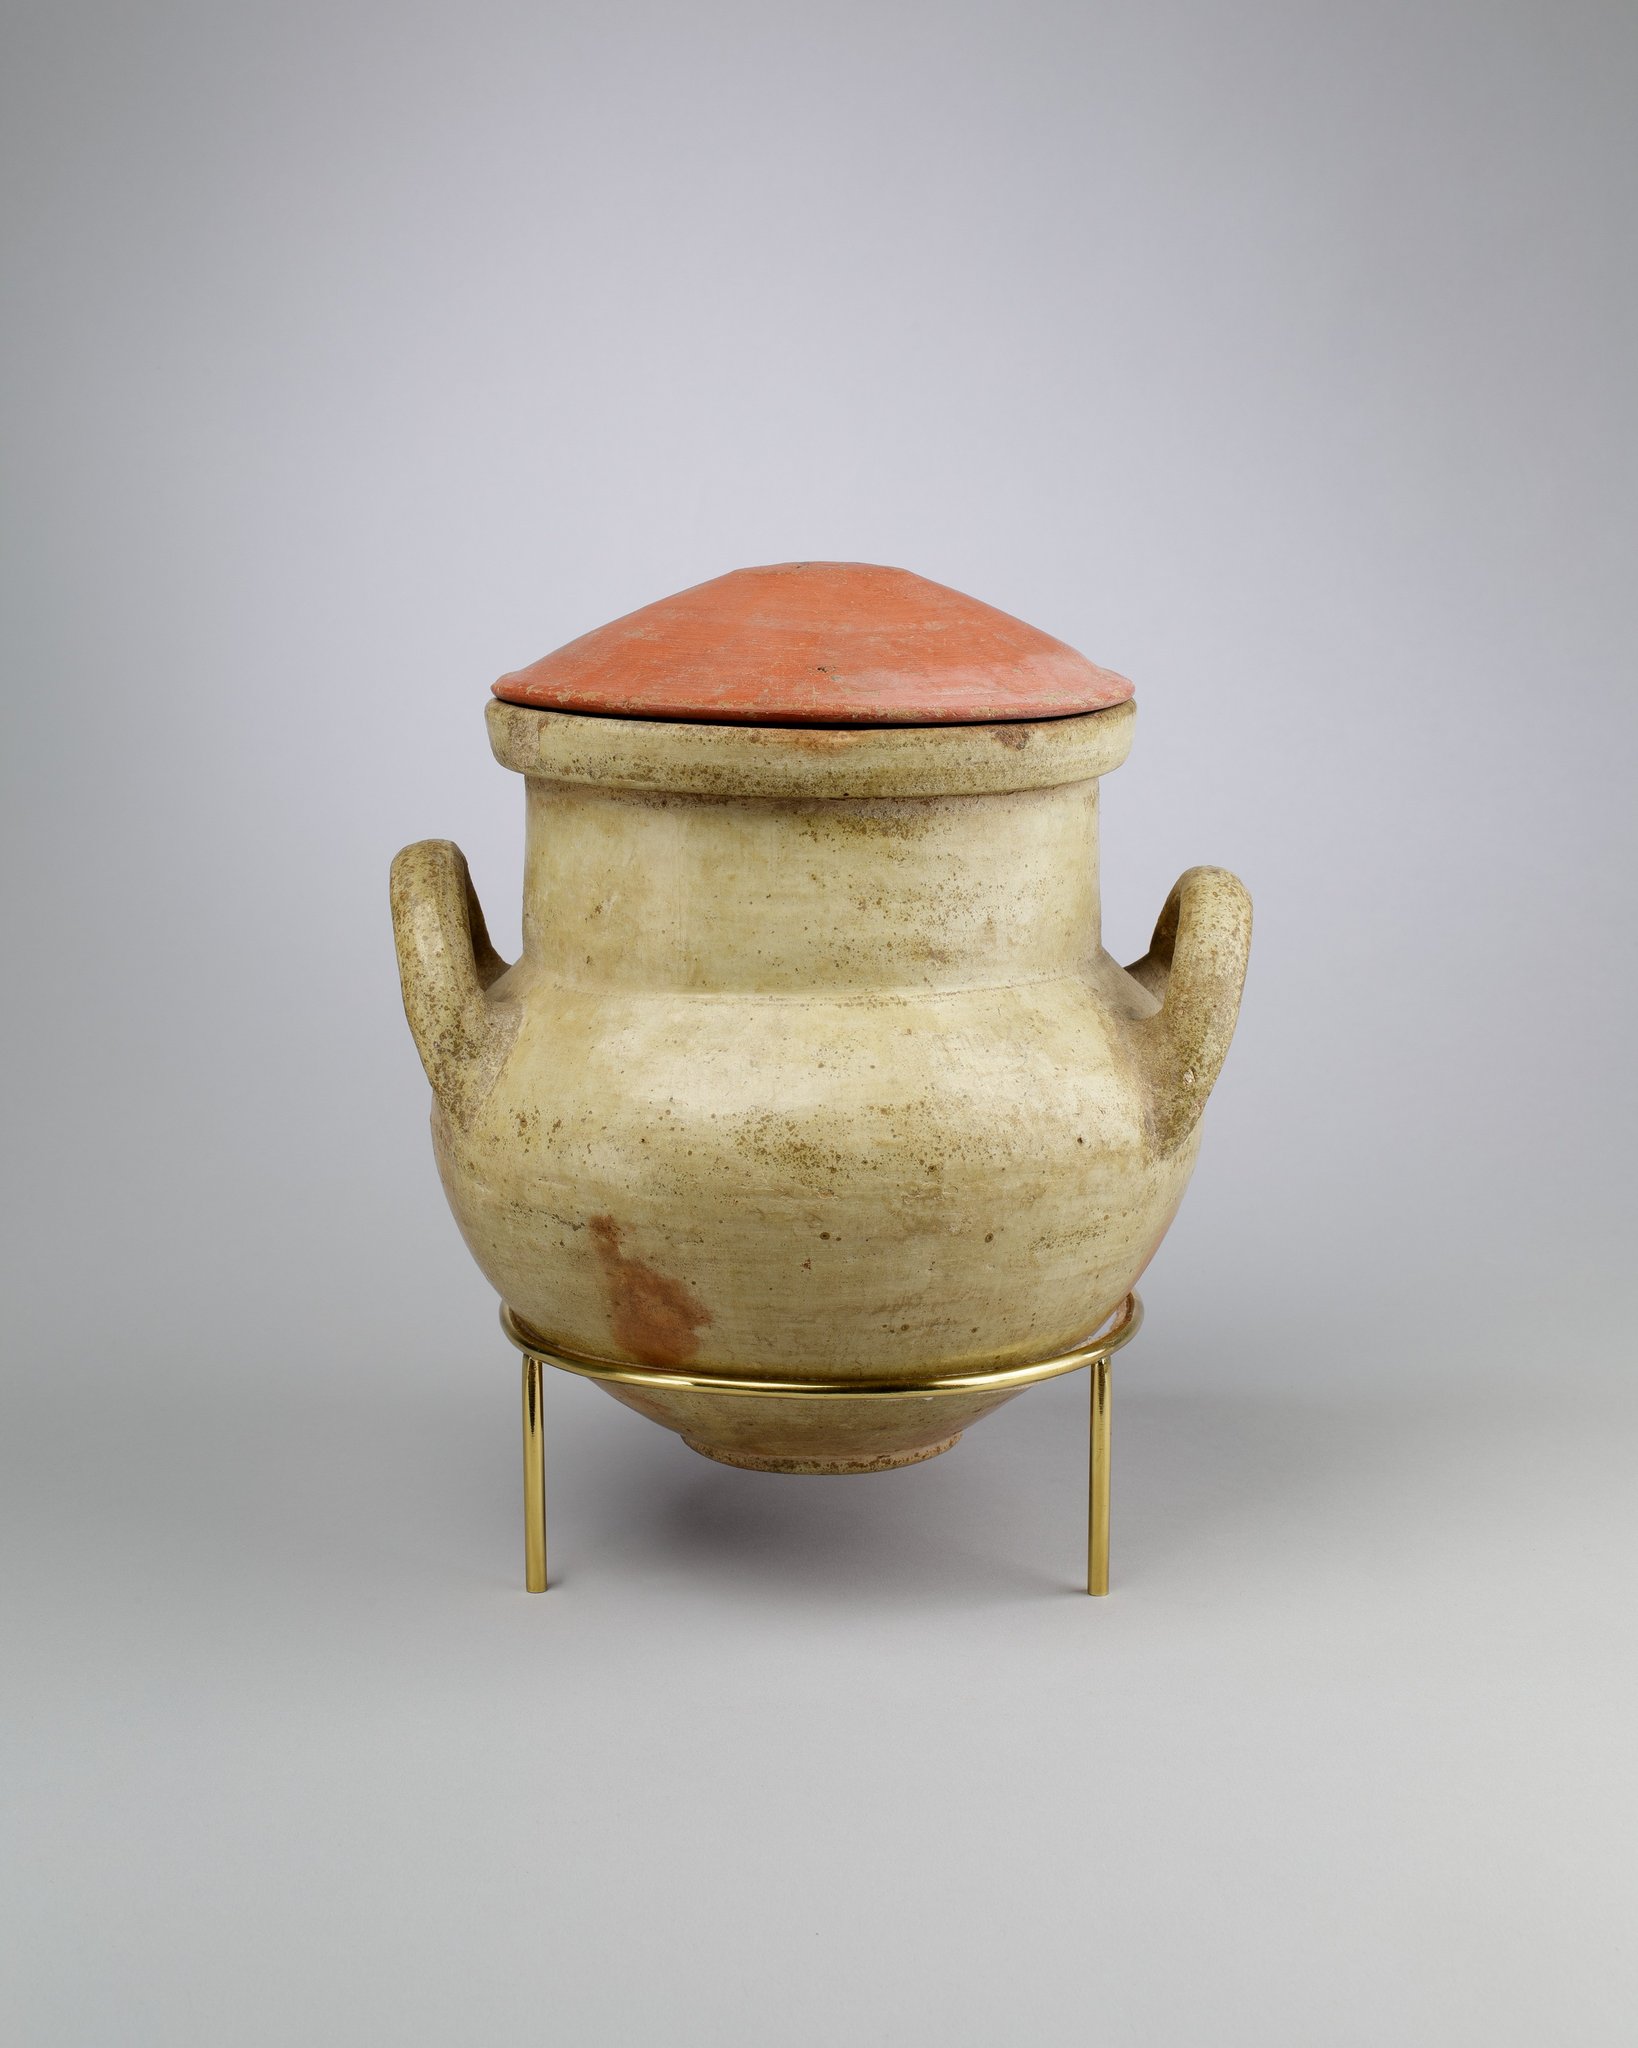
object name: vessel, strap handle, with lid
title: Vessel with strap handles and a lid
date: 1353-1336 BCE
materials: pottery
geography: egypt